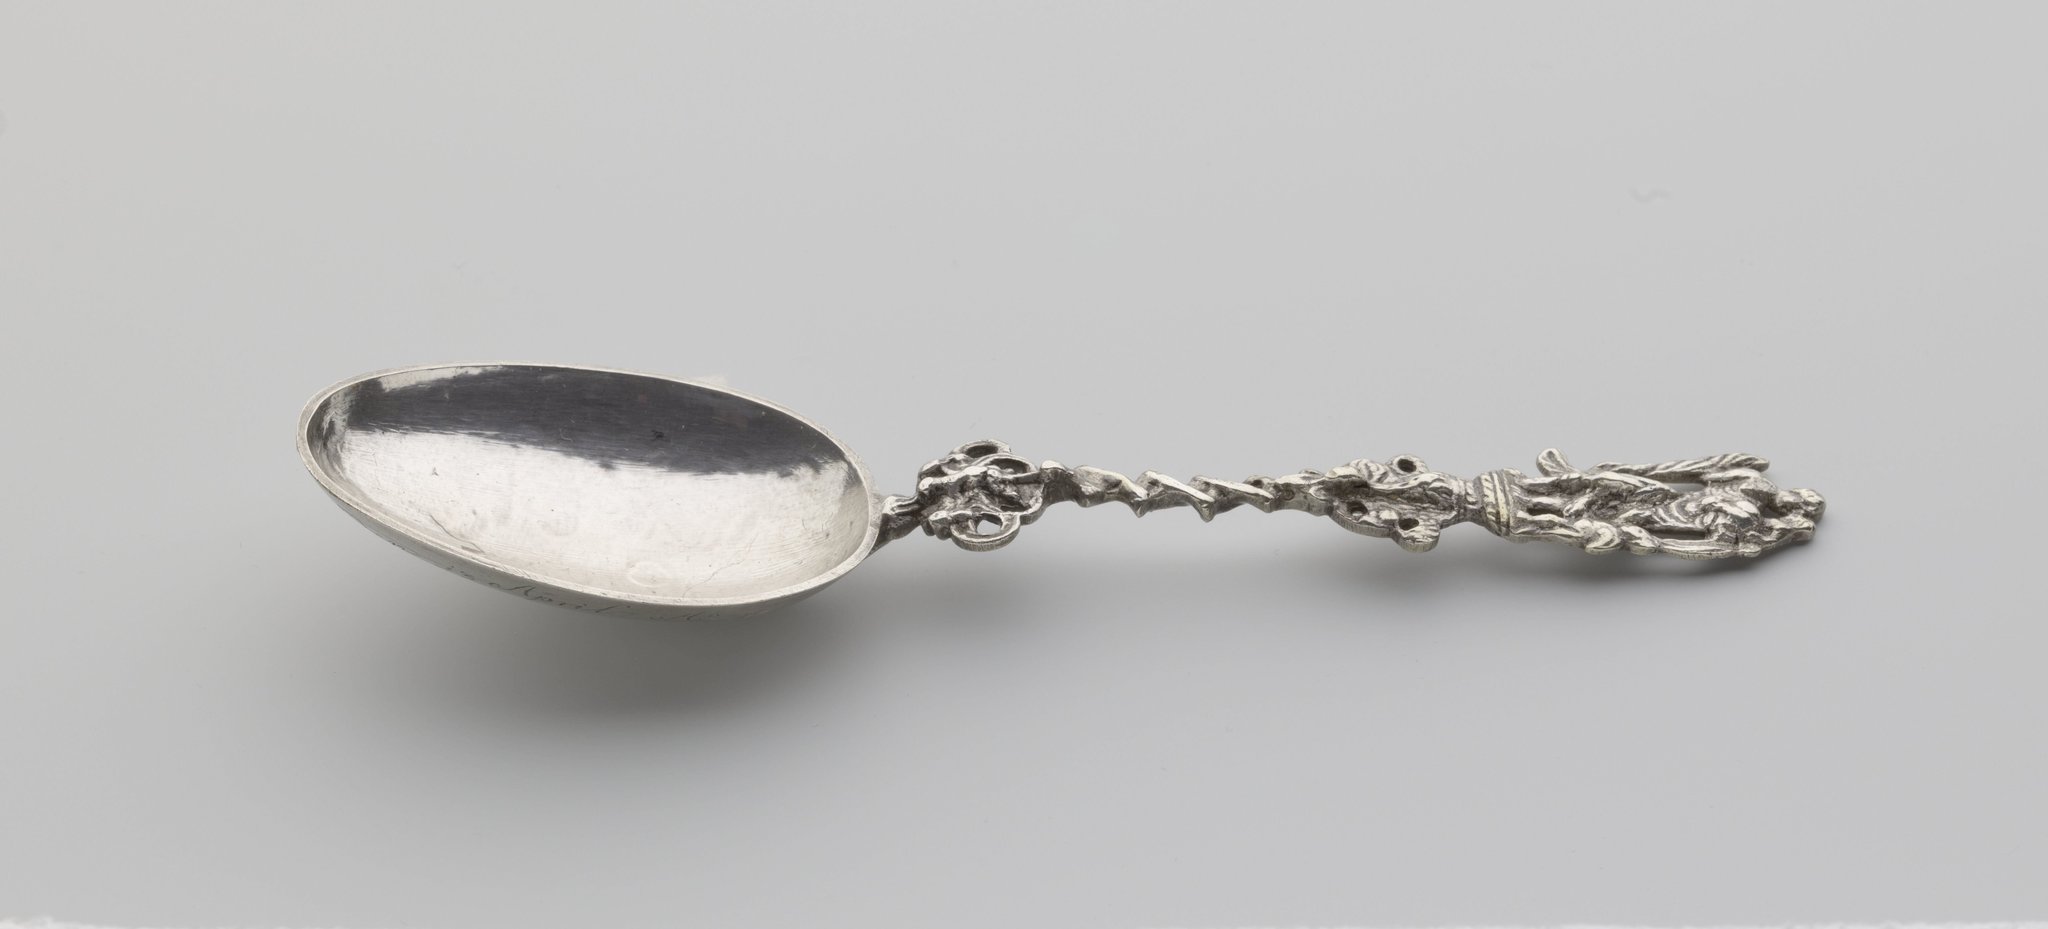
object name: spoon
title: Lepel van zilver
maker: johannes jorritsma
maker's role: silversmith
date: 1766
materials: silver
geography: franeker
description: Lepel van zilver, met een eivormige bak. De steel wordt bekroond met een voetstuk met daarop een vrouw met kind op de arm en een kind naast haar: Charitas. Op de onderzijde van de bak is gegraveerd: Thijs Feddes is Gebooren Den 13 April Ao 1766.